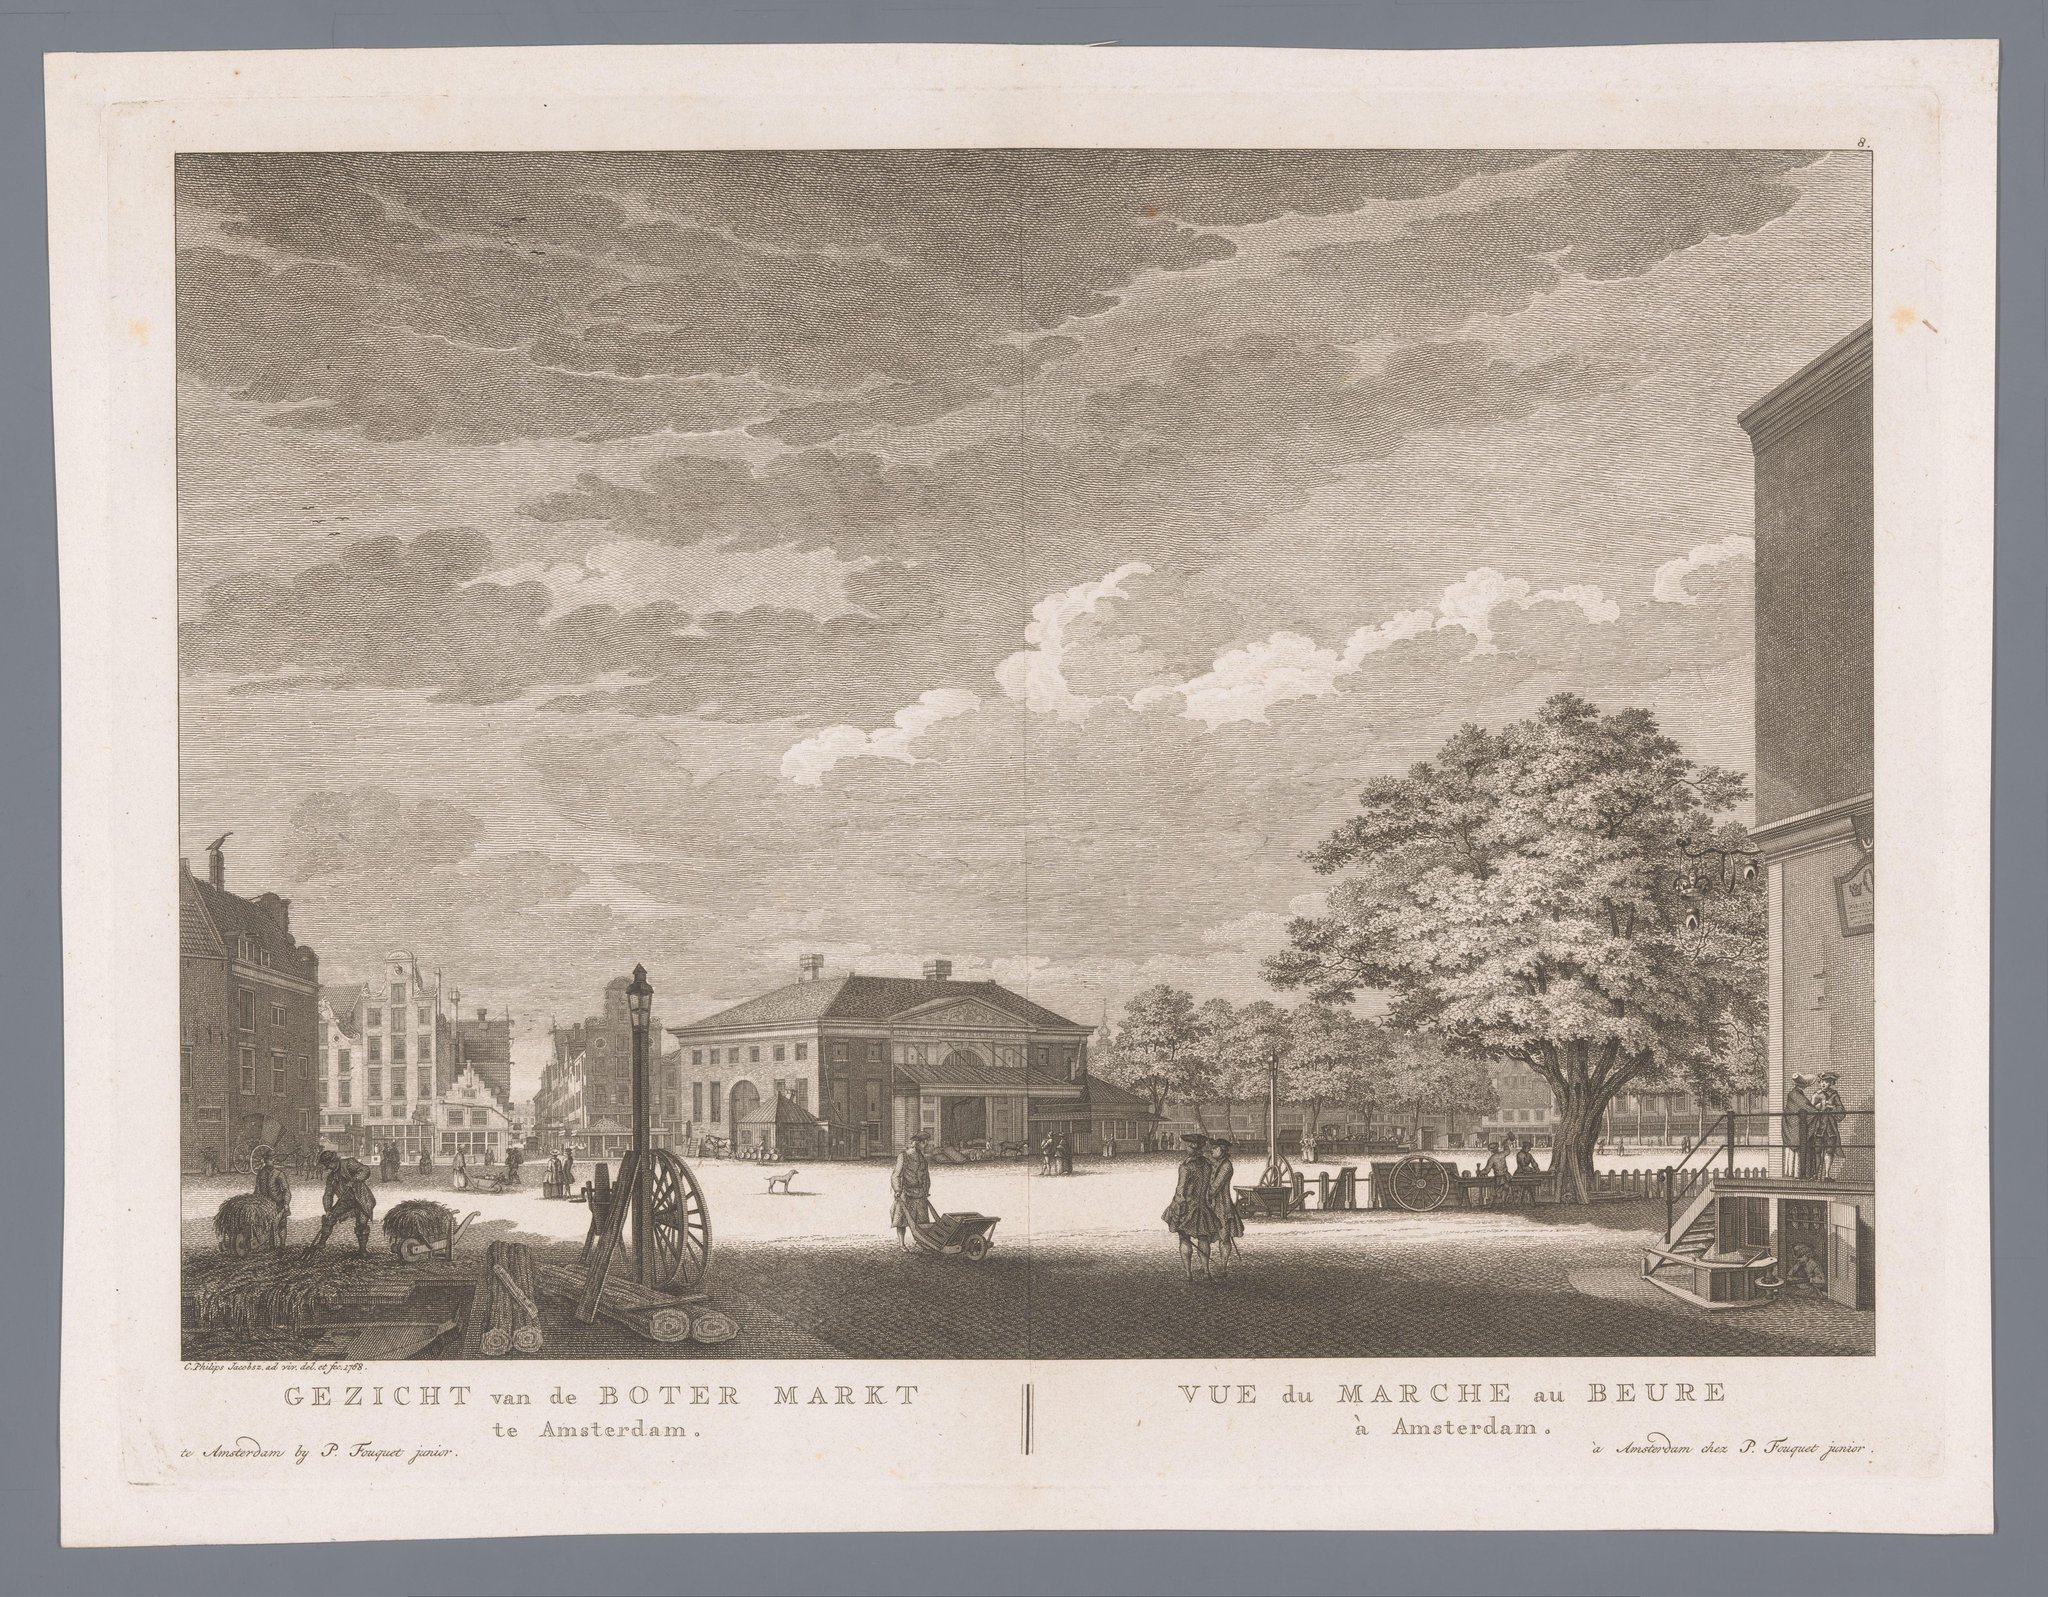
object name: print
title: Gezicht van de Boter Markt te Amsterdam / Vue du Marche au Beure à Amsterdam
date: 1774-1783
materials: paper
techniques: engraving, etching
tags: square, place, circus, etc., market-hall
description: Prent uit een van de edities van de Atlas Fouquet: Afbeeldingen van de wyd-vermaarde koopstad Amsterdam benevens des zelvs voornaamste gebouwen en gezigten alle naar het leeven getekend / Receuil des edifices les plus considerables et des plus belles vues, de la fameuse ville d'Amsterdam, dessinées d'après nature. Amsterdam: Pierre Fouquet, 1778-1783. En: Nieuwe atlas, van de voornaamste gebouwen en gezigten der stad Amsterdam, met derzelver beknopte beschryvingen. 2 dln. Amsterdam: Daniël Jean Changuion en Petrus den Hengst [in opdracht van Pierre Fouquet], 1783. Een latere staat komt voor in: Nieuwe atlas, van de voornaamste gebouwen en gezigten der stad Amsterdam. Met derzelver beknopte beschryvingen. Amsterdam: Evert Maaskamp, 1805.